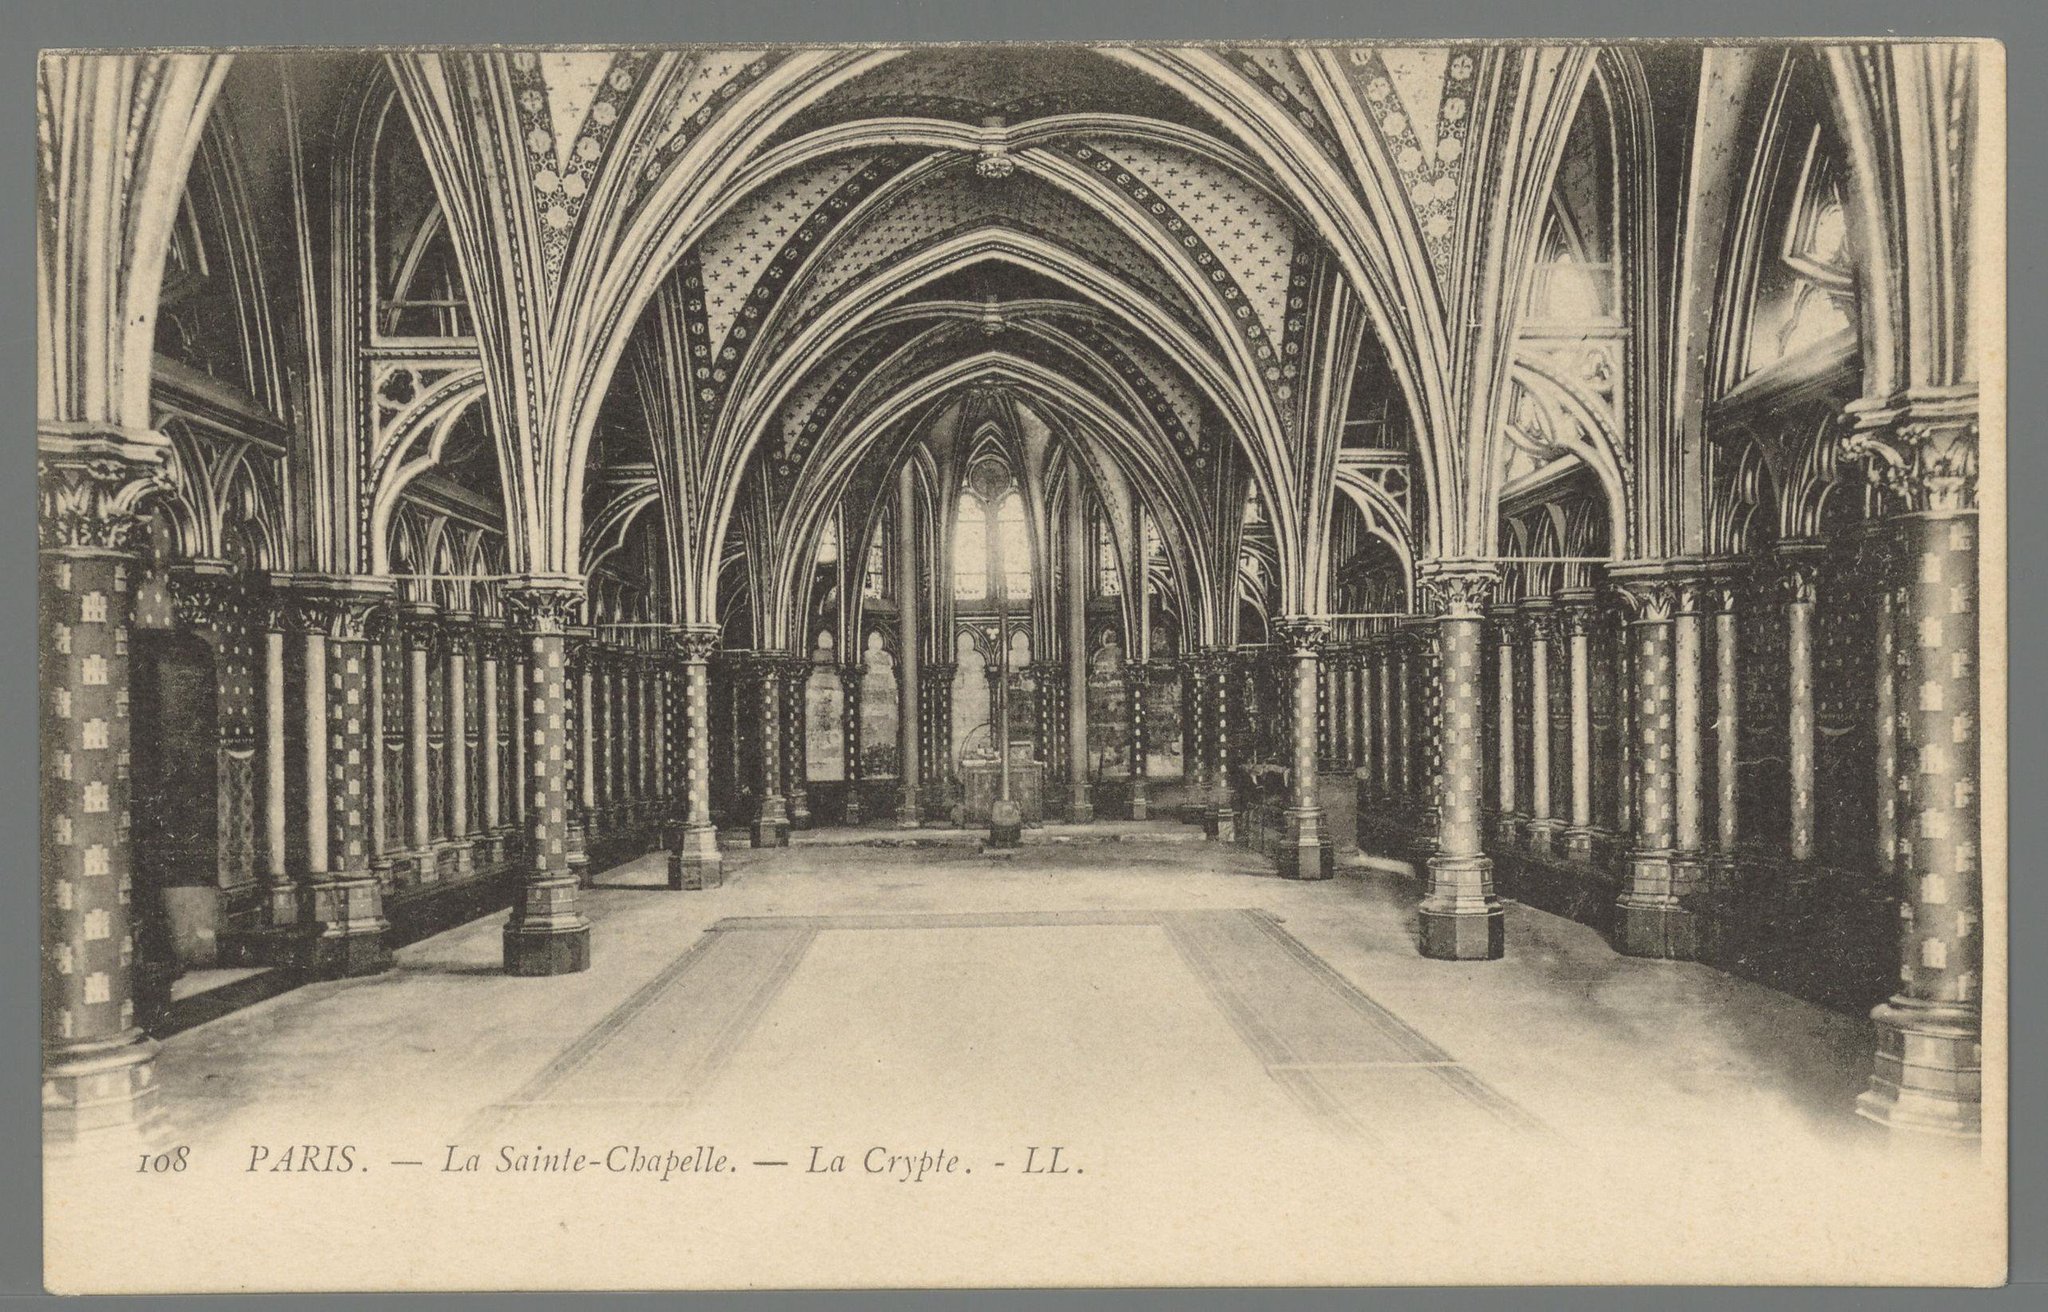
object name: photomechanical print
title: Paris. La Sainte-Chapelle. La Crypte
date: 1895-1904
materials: cardboard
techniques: photograph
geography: paris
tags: parts of church interior (crypt)